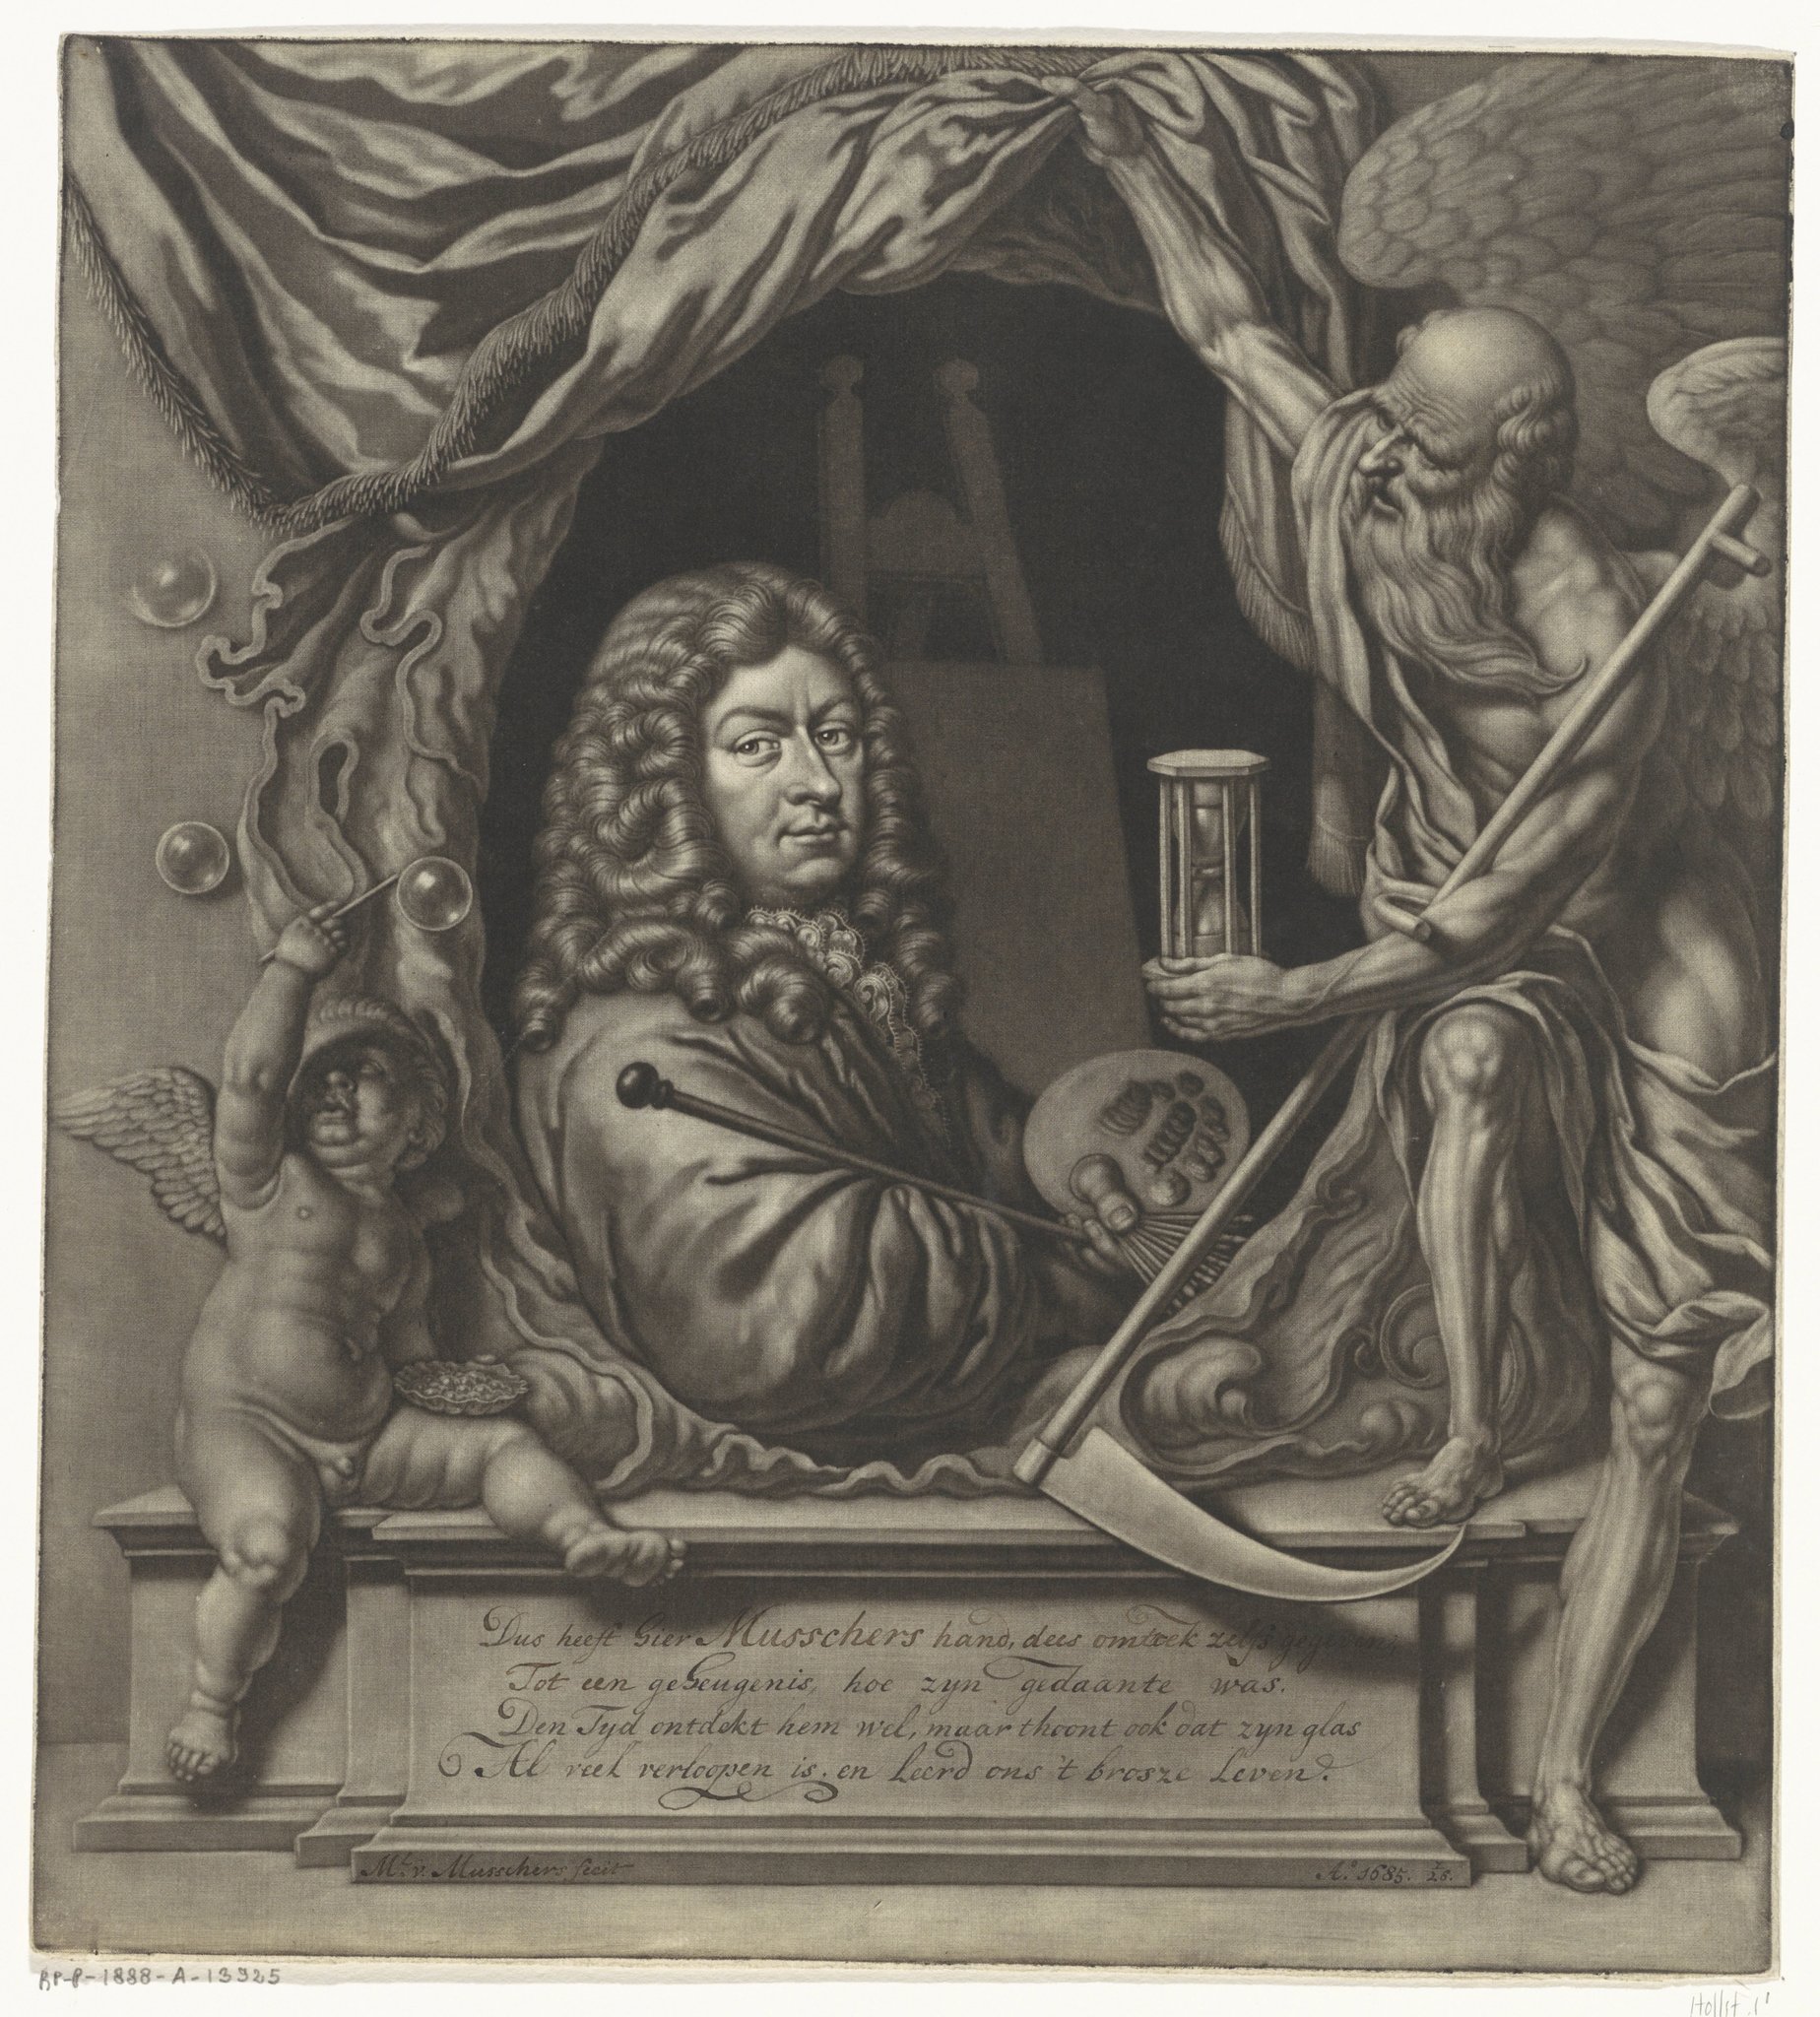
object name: print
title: Zelfportret van Michiel van Musscher in allegorische omlijsting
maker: michiel van musscher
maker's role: draughtsman, painter, print maker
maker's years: 1645-1705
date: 1685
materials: paper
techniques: mezzotint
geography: northern netherlands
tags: amsterdam, painter, print maker, draughtsman, michiel van musscher, portrait, self-portrait of painter, father time, man with wings and scythe, (children or putti) blowing bubbles, 'homo bulla' ~ scene symbolizing 'vanitas'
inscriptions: collector's mark: Lugt 2228, inscription: ‘Dus heeft [...] Leven. / M [...] 1685. [...]’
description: Michiel van Musscher, in een cartouche, met palet en penselen als de attributen van de schilderkunst. Allegorische figuren omringen zijn portret en verwijzen naar de vergankelijke tijd en de onsterfelijkheid van de kunstenaar door middel van zijn roem. Het vers op het tablet vermeldt dat vader Tijd het doek licht om de grootheid van de schilder te onthullen, maar verwijst tevens naar de zandloper die aangeeft dat zijn leven al gedeeltelijk voorbij is. Dit laatste wordt nog eens benadrukt door de zeepbellen, geblazen door de putto, die de vergankelijkheid van het menselijk leven symboliseren.